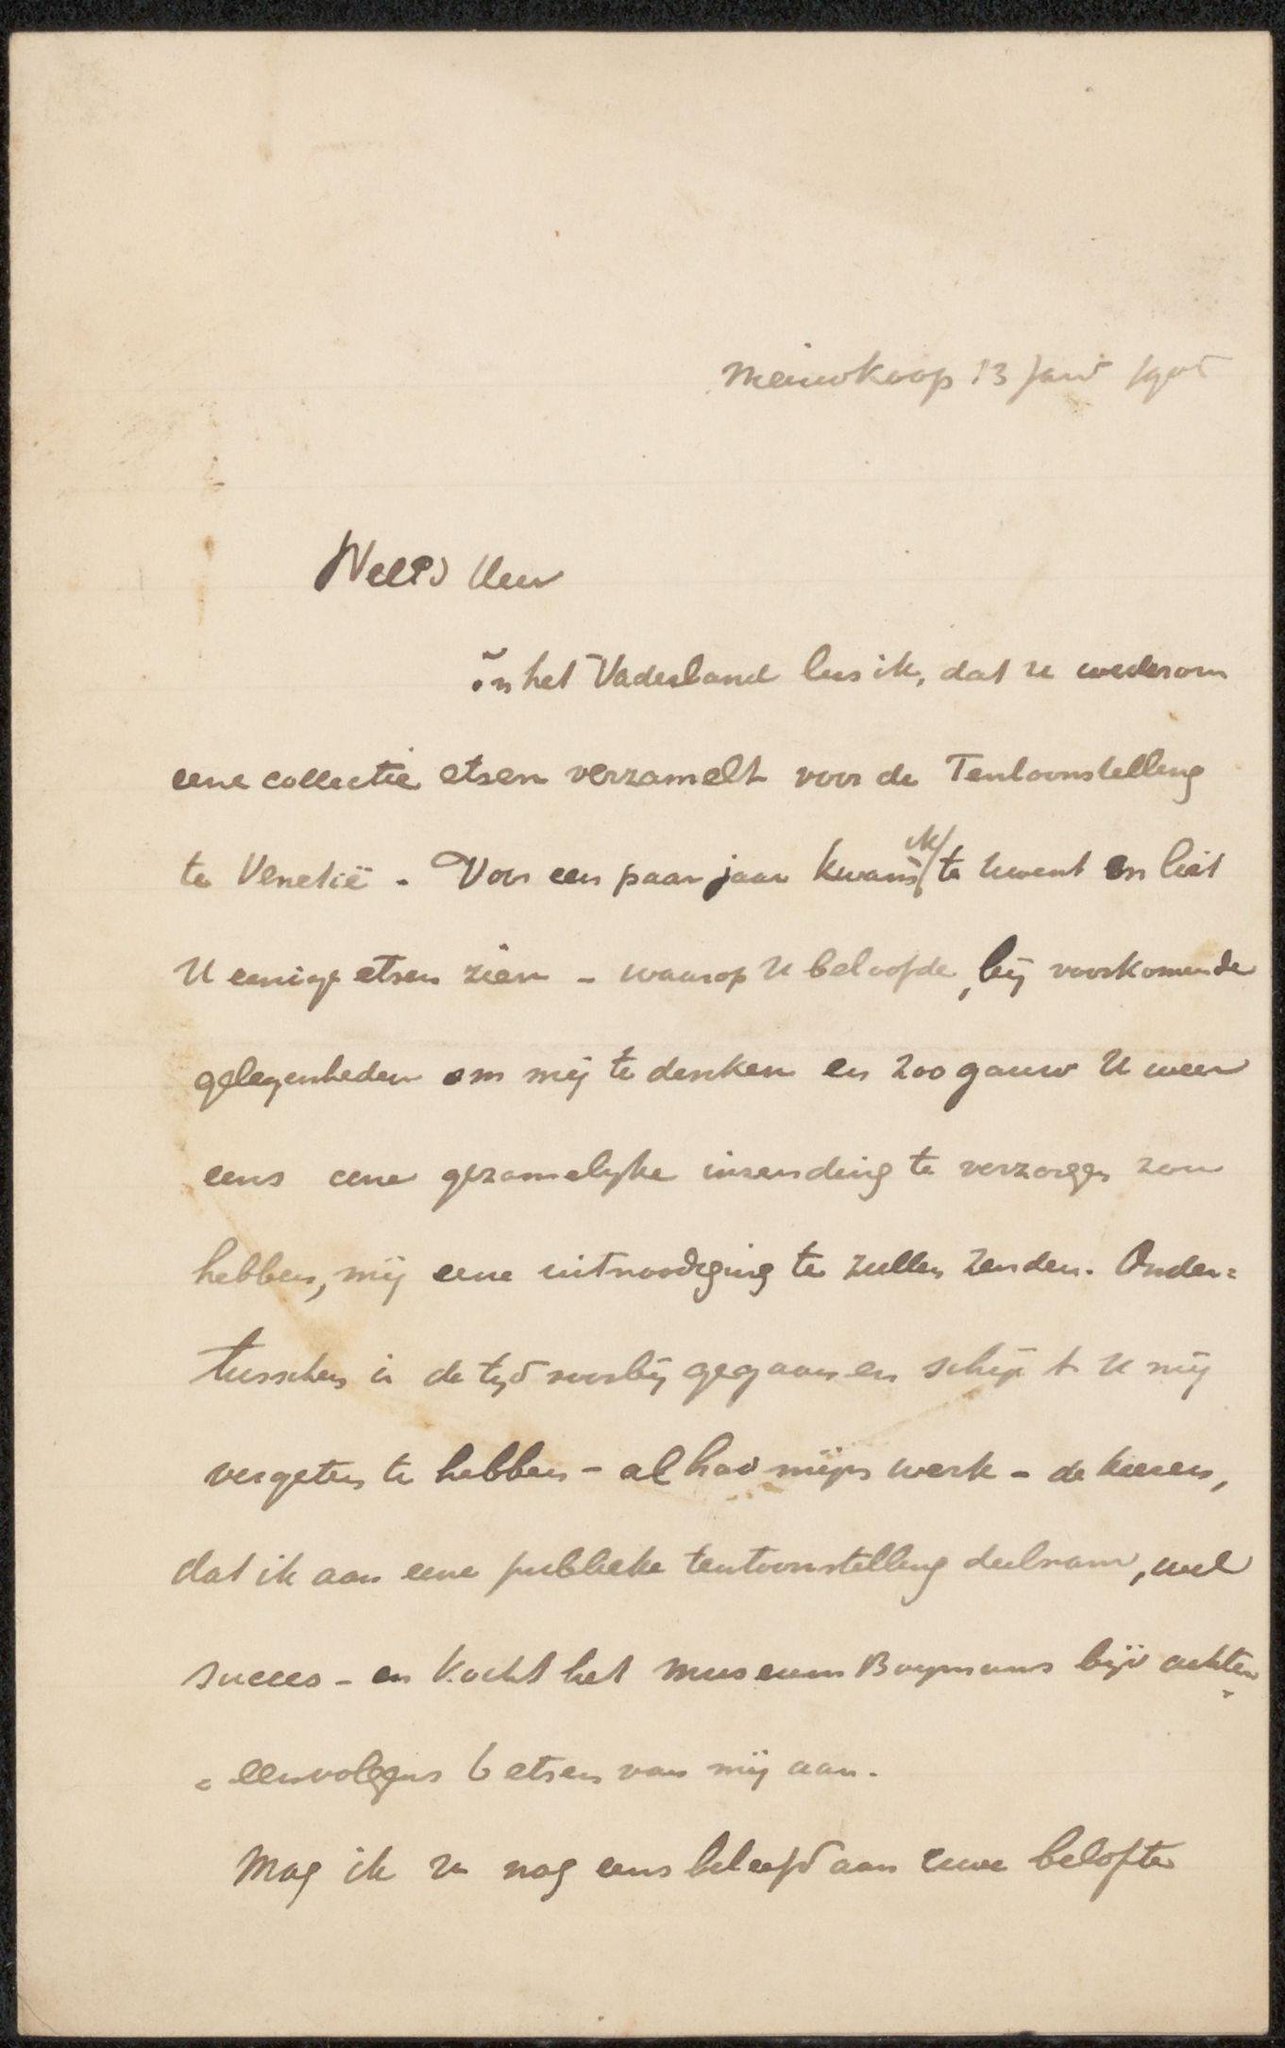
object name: letter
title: Brief aan Philip Zilcken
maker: waalko jans dingemans (i)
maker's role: draughtsman, print maker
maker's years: 1873-1925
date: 1905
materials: ink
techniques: pen, writing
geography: nieuwkoop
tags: painter, draughtsman, philip zilcken, the graphic arts, exhibition ~ art, art collecting, venice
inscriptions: collector's mark: ‘RPK’